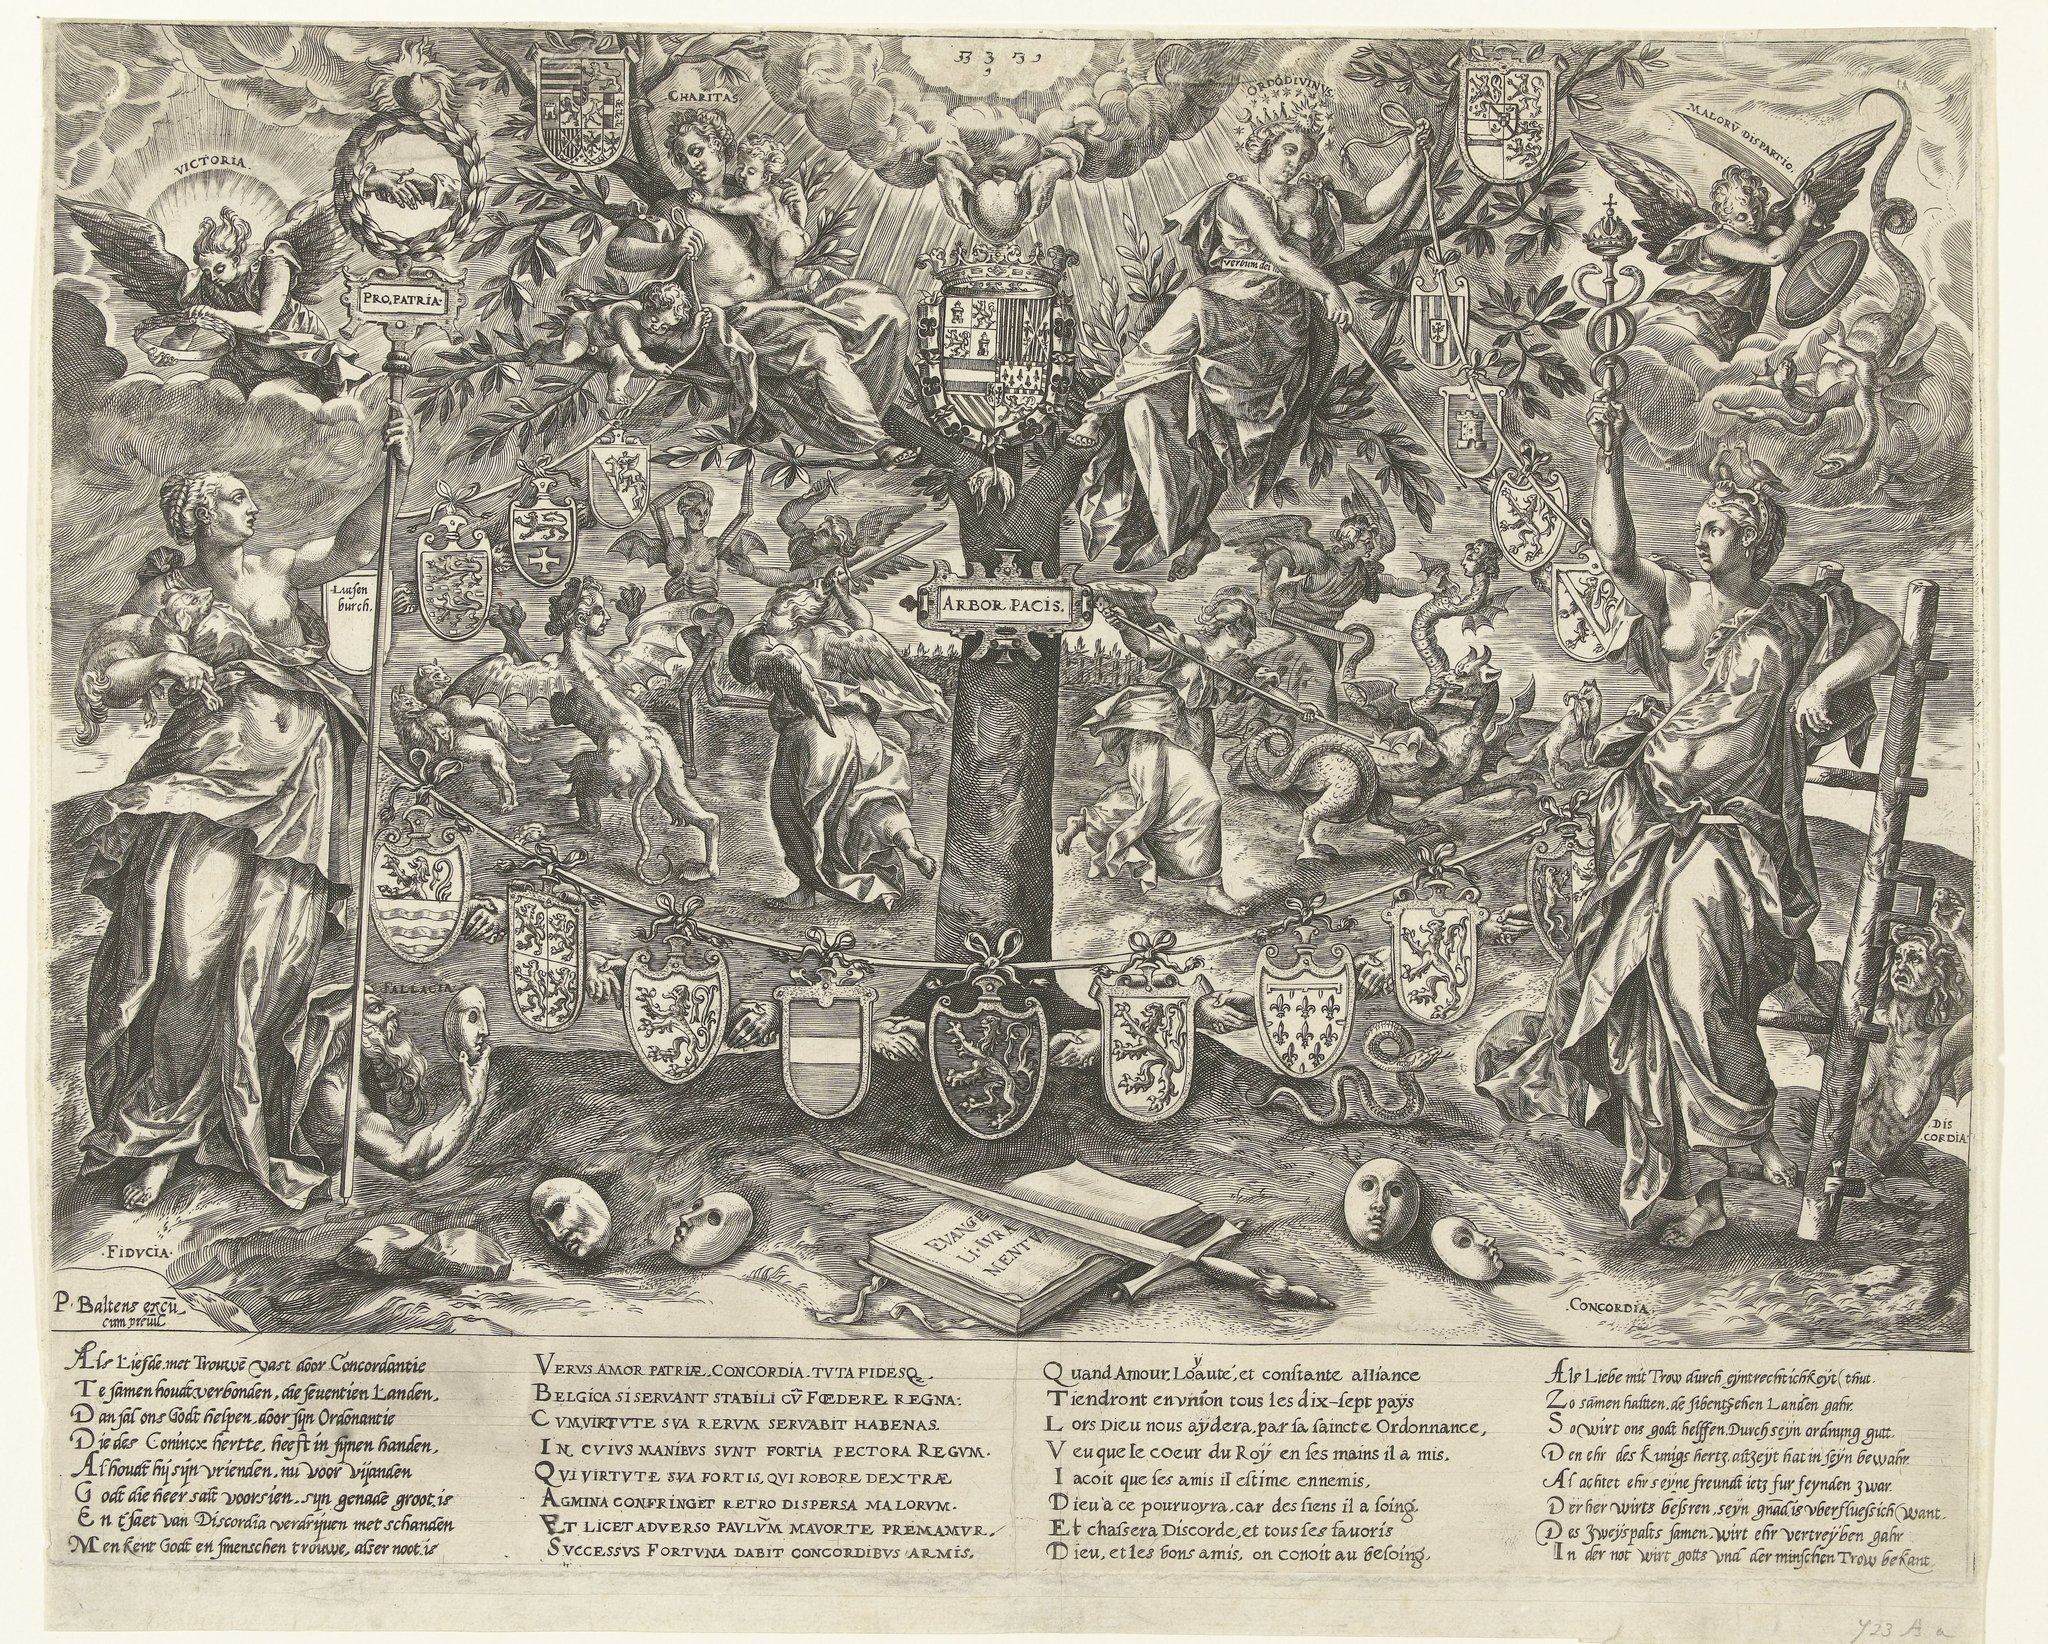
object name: propagandaprent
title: Arbor Pacis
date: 1578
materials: paper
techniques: engraving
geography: antwerp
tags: philip ii of spain, vienna, matthias van oostenrijk (rooms-duits keizer), william i (prince of orange), agreement, unity; 'concordia', 'concordia insuperabile', 'concordia militare', 'concordia di pace', 'unione civile' (ripa), charity, 'caritas'; 'carità' (ripa) ~ one of the three theological virtues, fidelity; 'fedeltà' (ripa), disagreement, discord; 'discordia' (ripa), delusion, fallacy; 'prima impressione' (ripa), trees (+ plants used symbolically)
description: Deze staat niet vermeld in Frederik Muller.